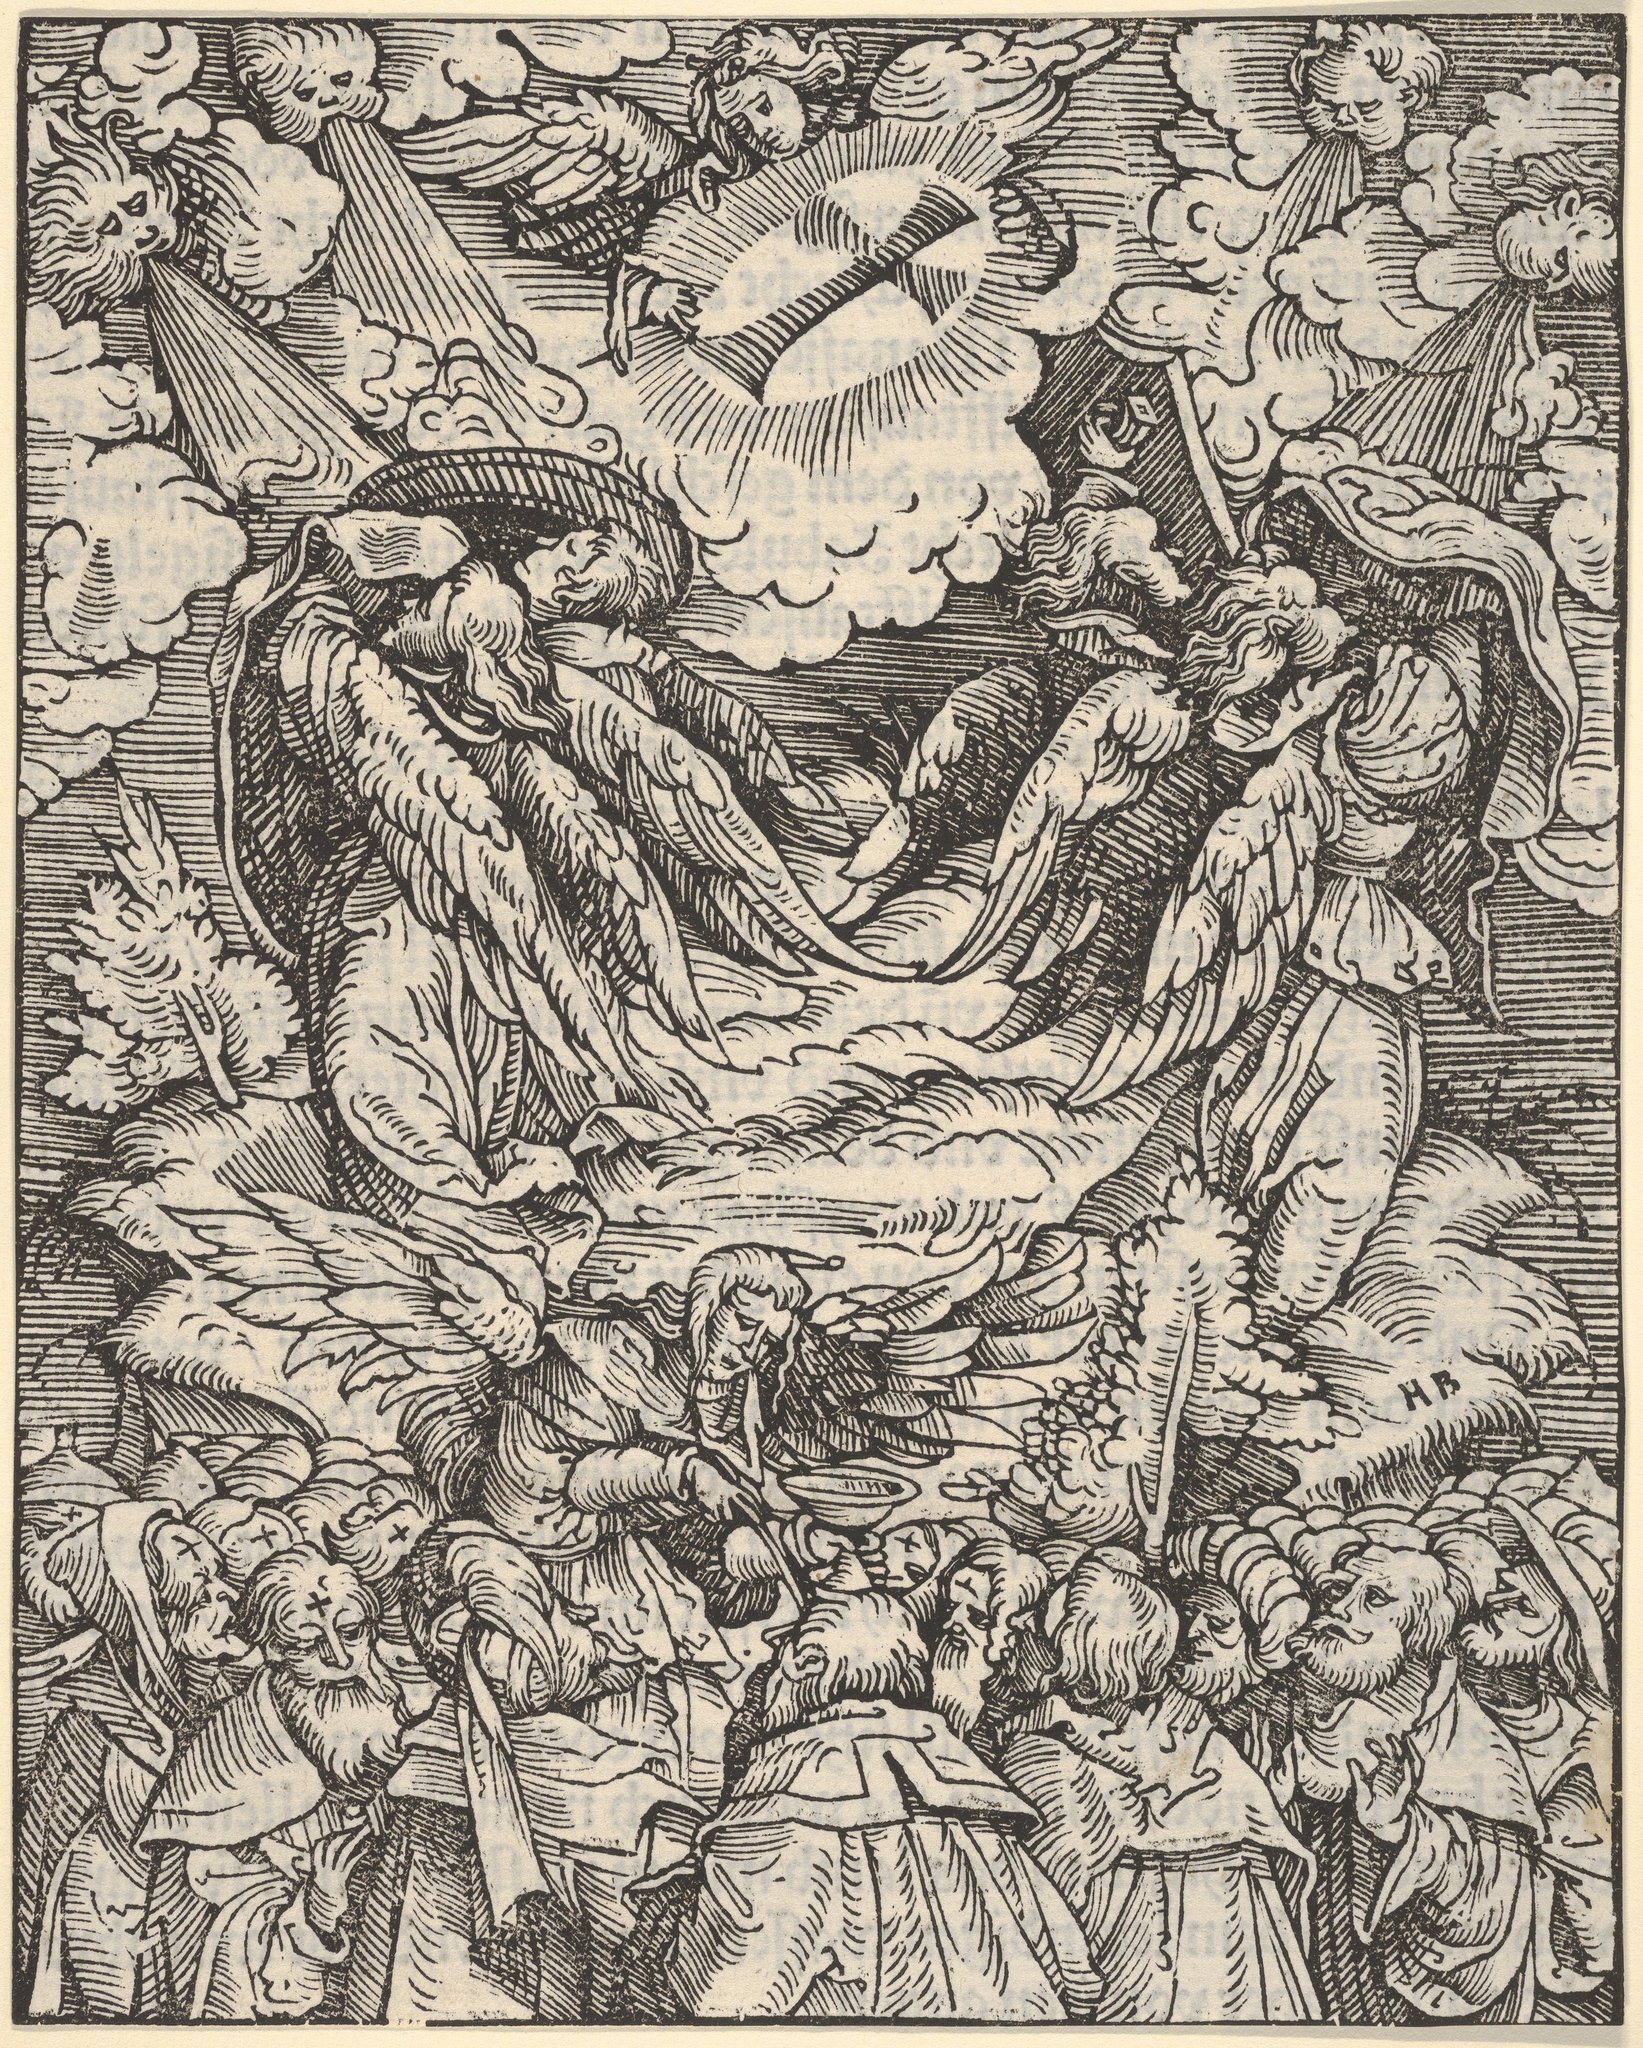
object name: print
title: Designation of the Elect, plate 6 from The Apocalypse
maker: hans burgkmair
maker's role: artist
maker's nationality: german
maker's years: 1473-1531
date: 1523-1524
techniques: woodcut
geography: augsburg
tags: angels,cross,apocalypse